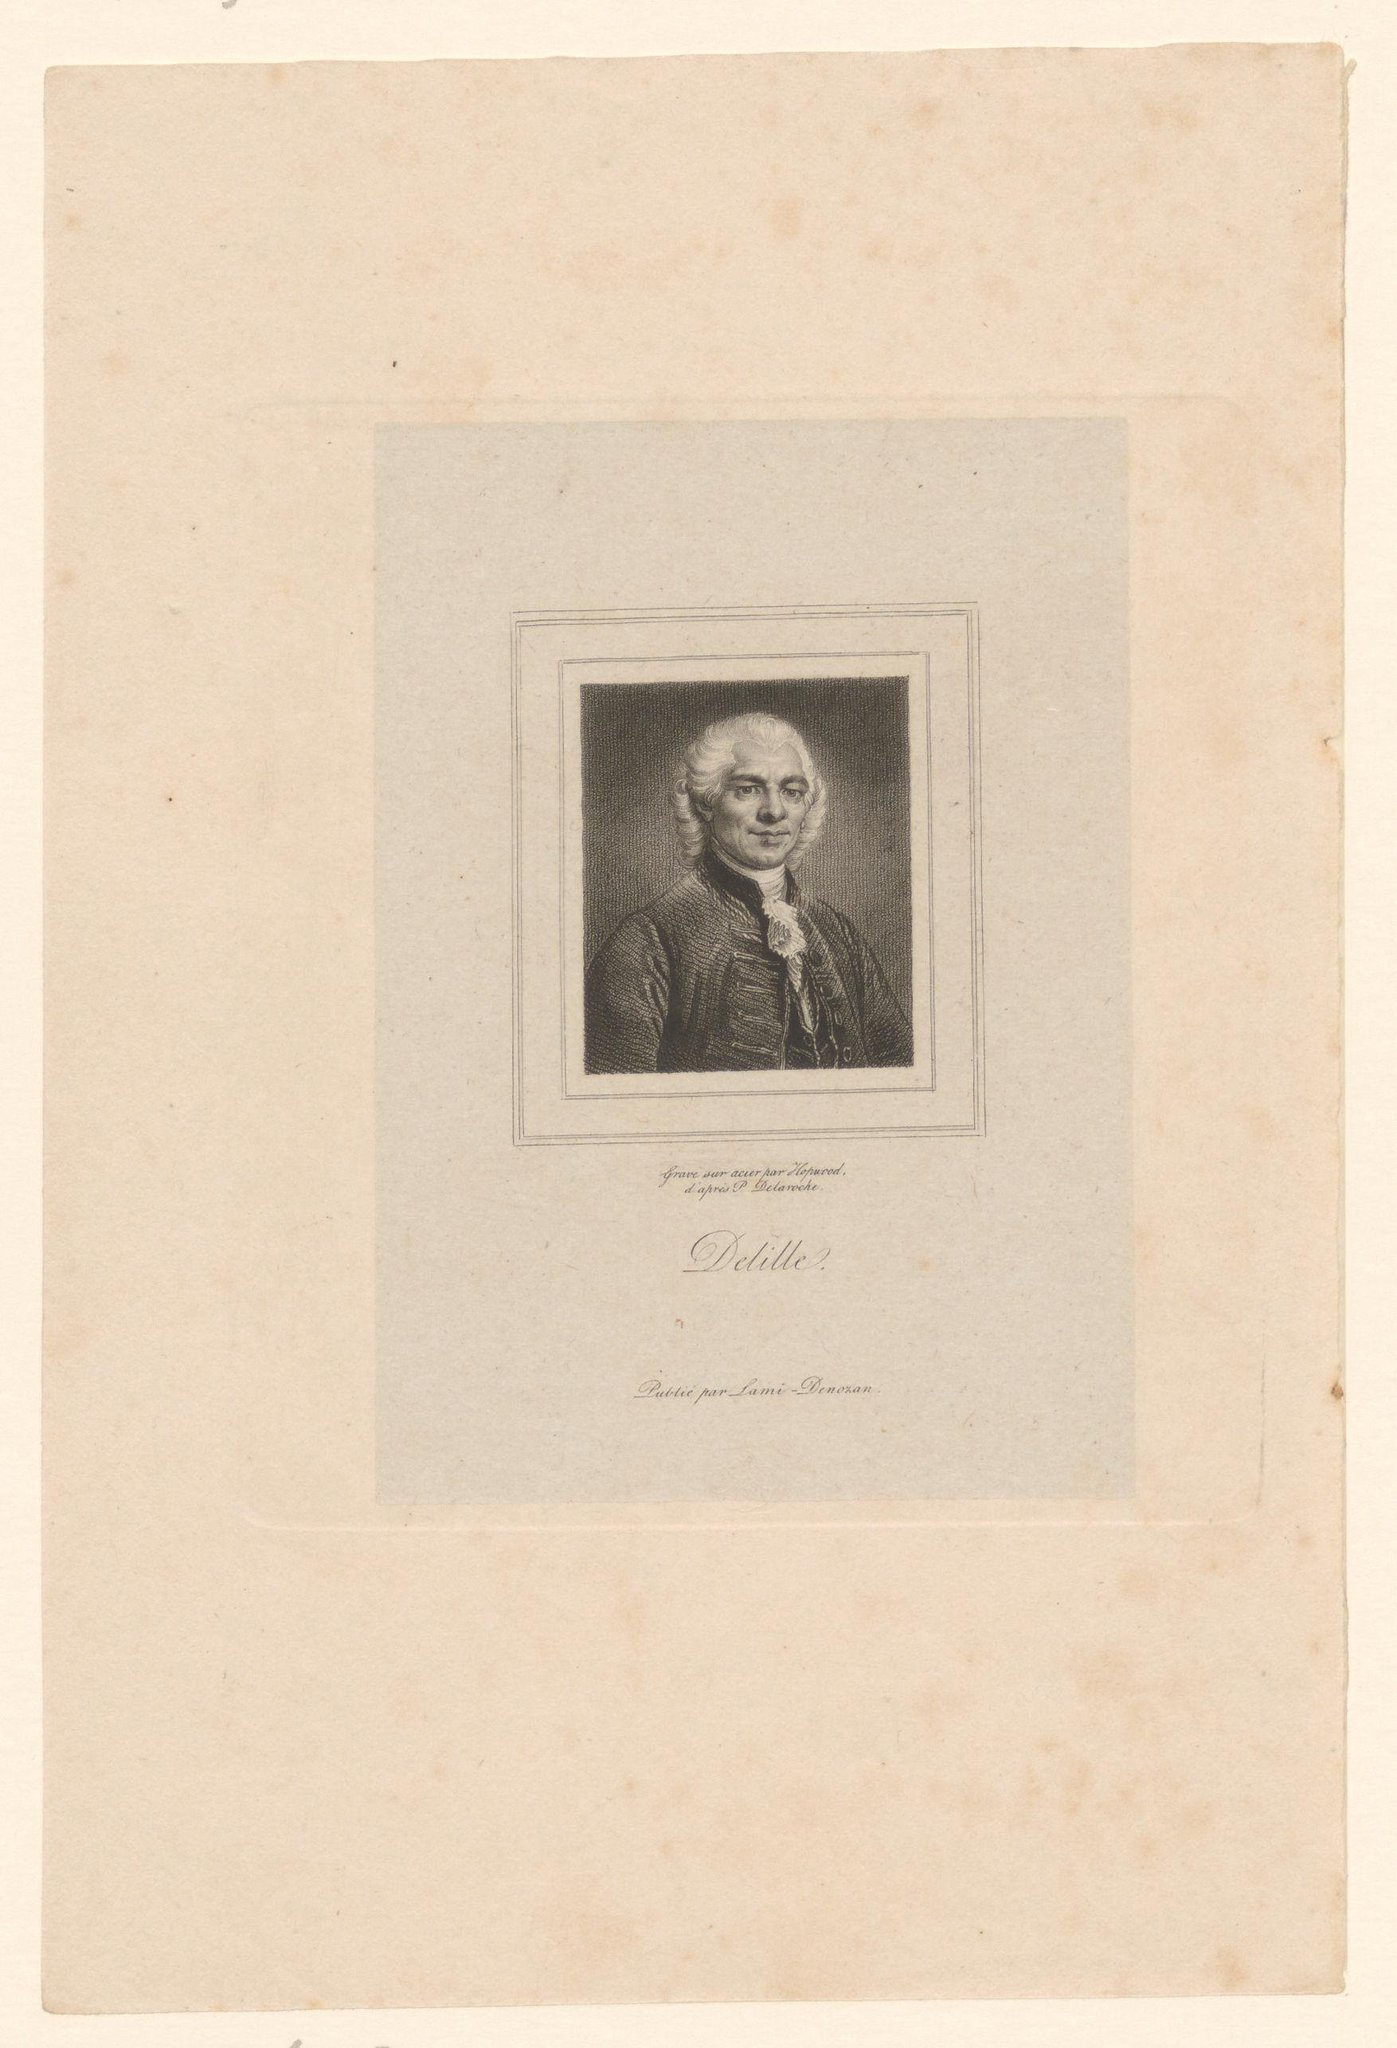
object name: print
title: Delille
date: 1828-1850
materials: paper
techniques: etching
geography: paris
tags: paris, jacques delille, historical persons, portrait of a writer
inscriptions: check stamp: ‘A[?]’, collector's mark: Lugt 2228